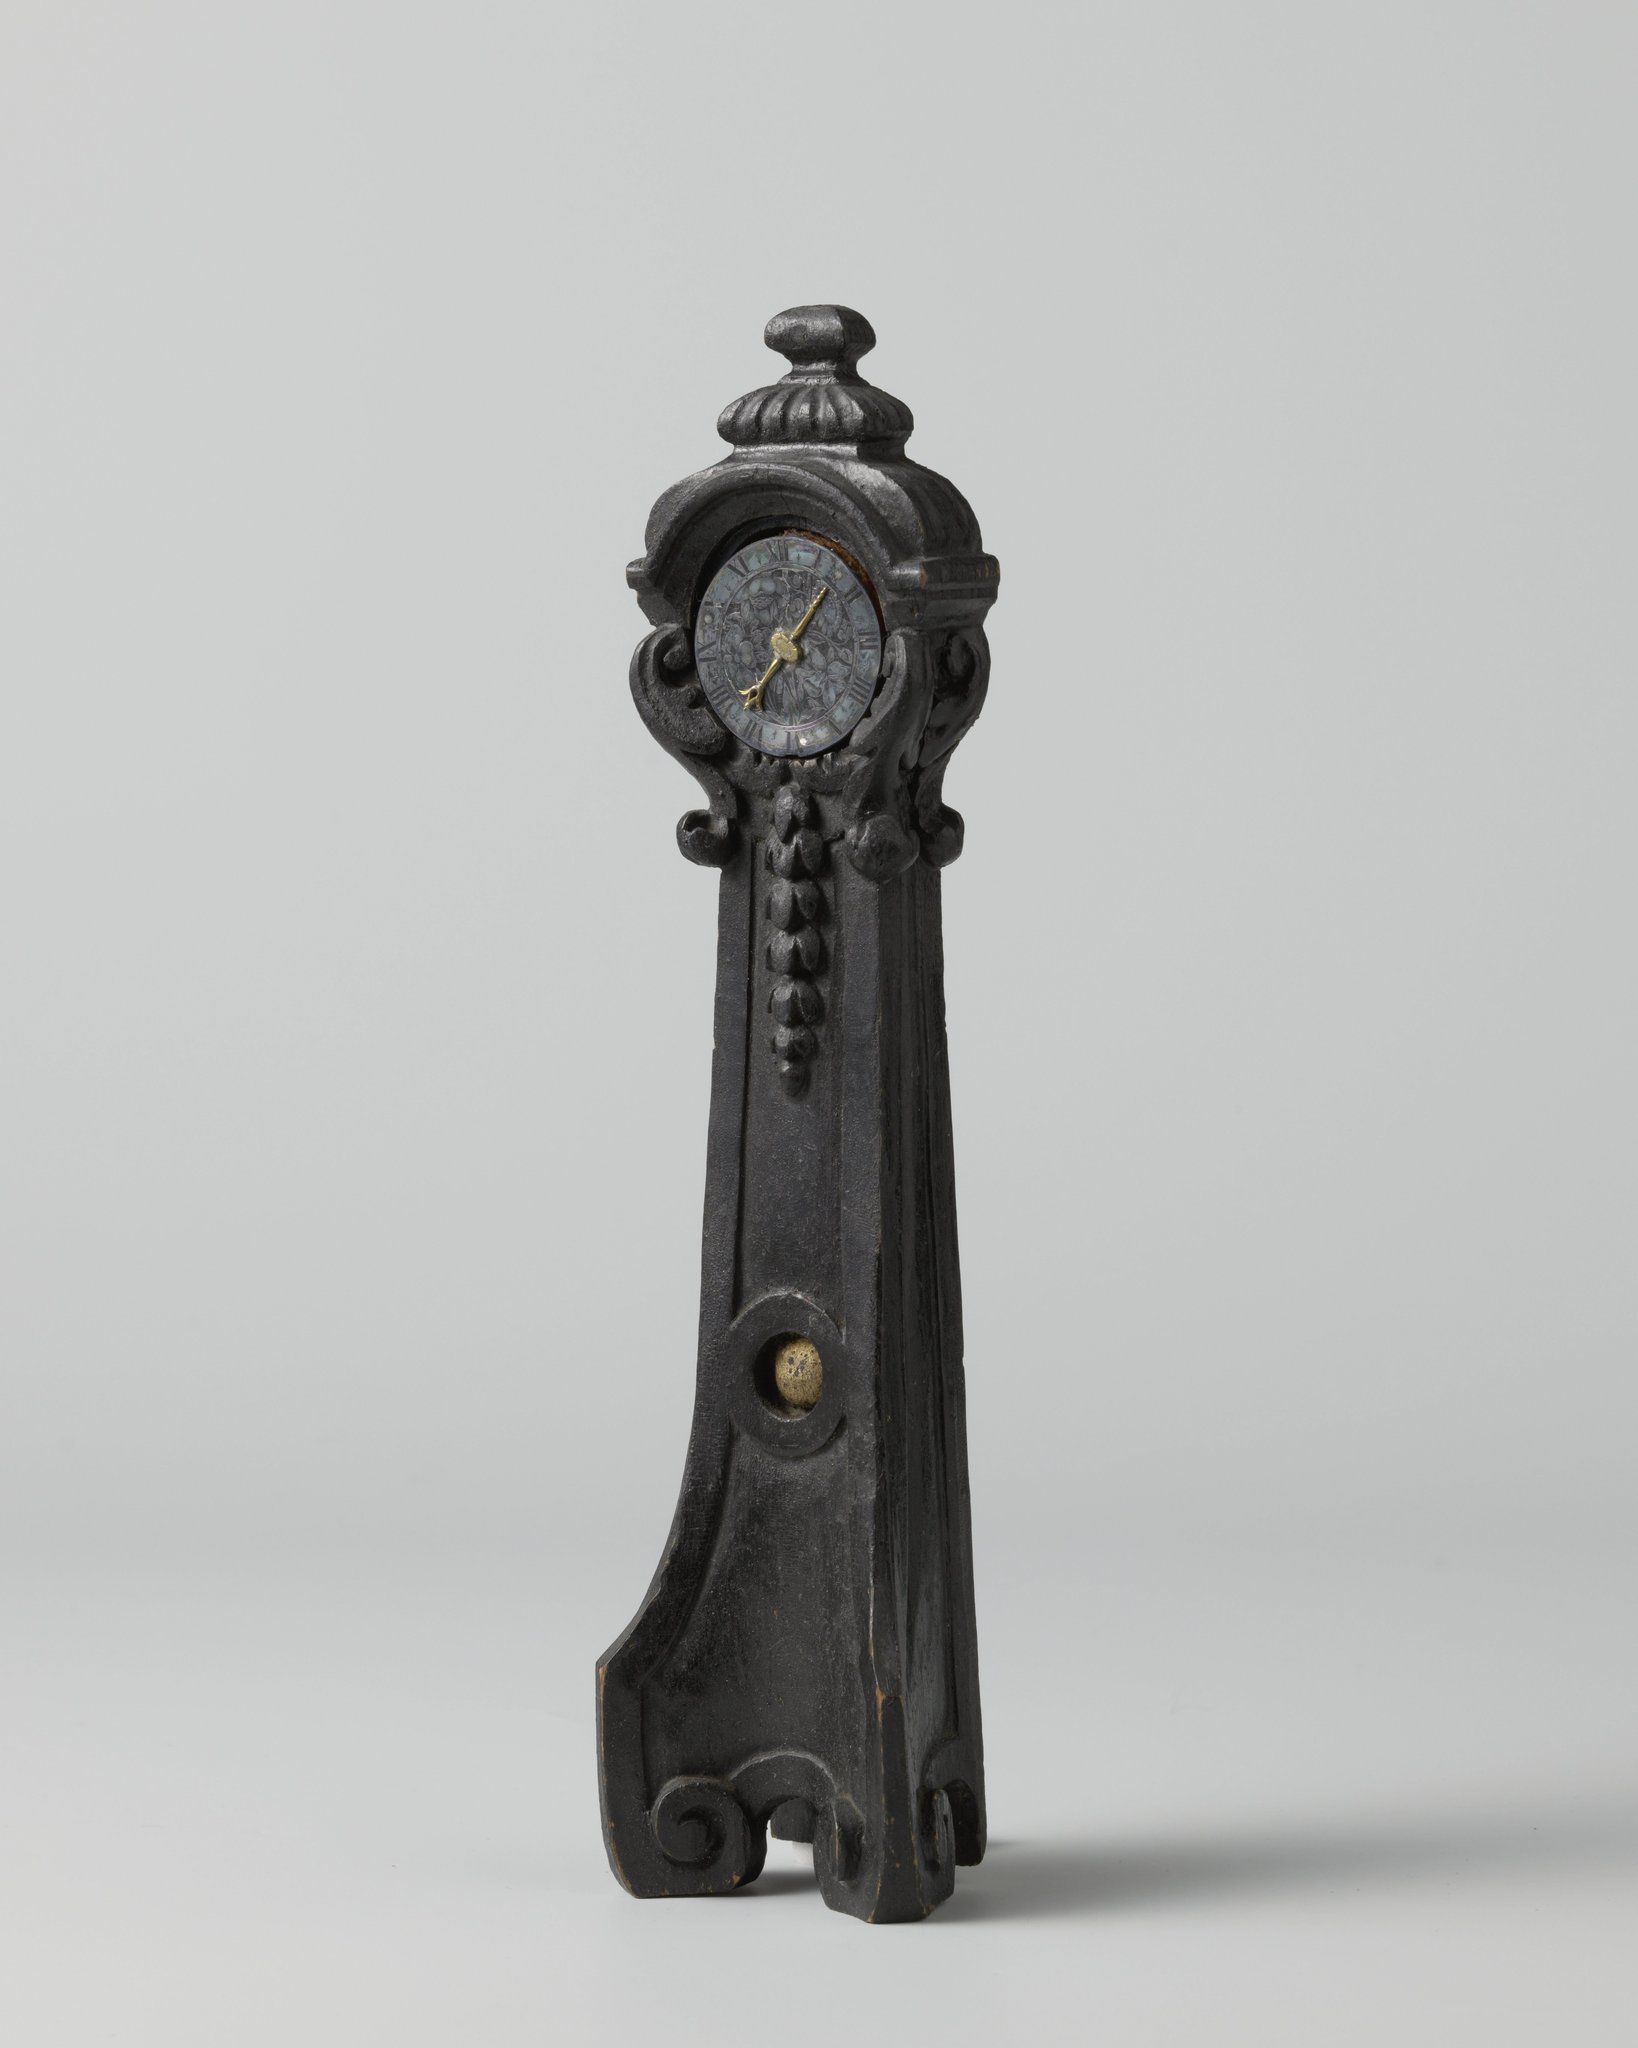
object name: longcase clock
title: Staande klok, miniatuur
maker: Anonymous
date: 1700-1720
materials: gold, wood, silver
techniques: engraving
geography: amsterdam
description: Staande klok, gesneden uit een massief stuk zwart gebeitst hout. De wijzerplaat is van zilver, gegraveerd met bloemen, de wijzers zijn van goud.